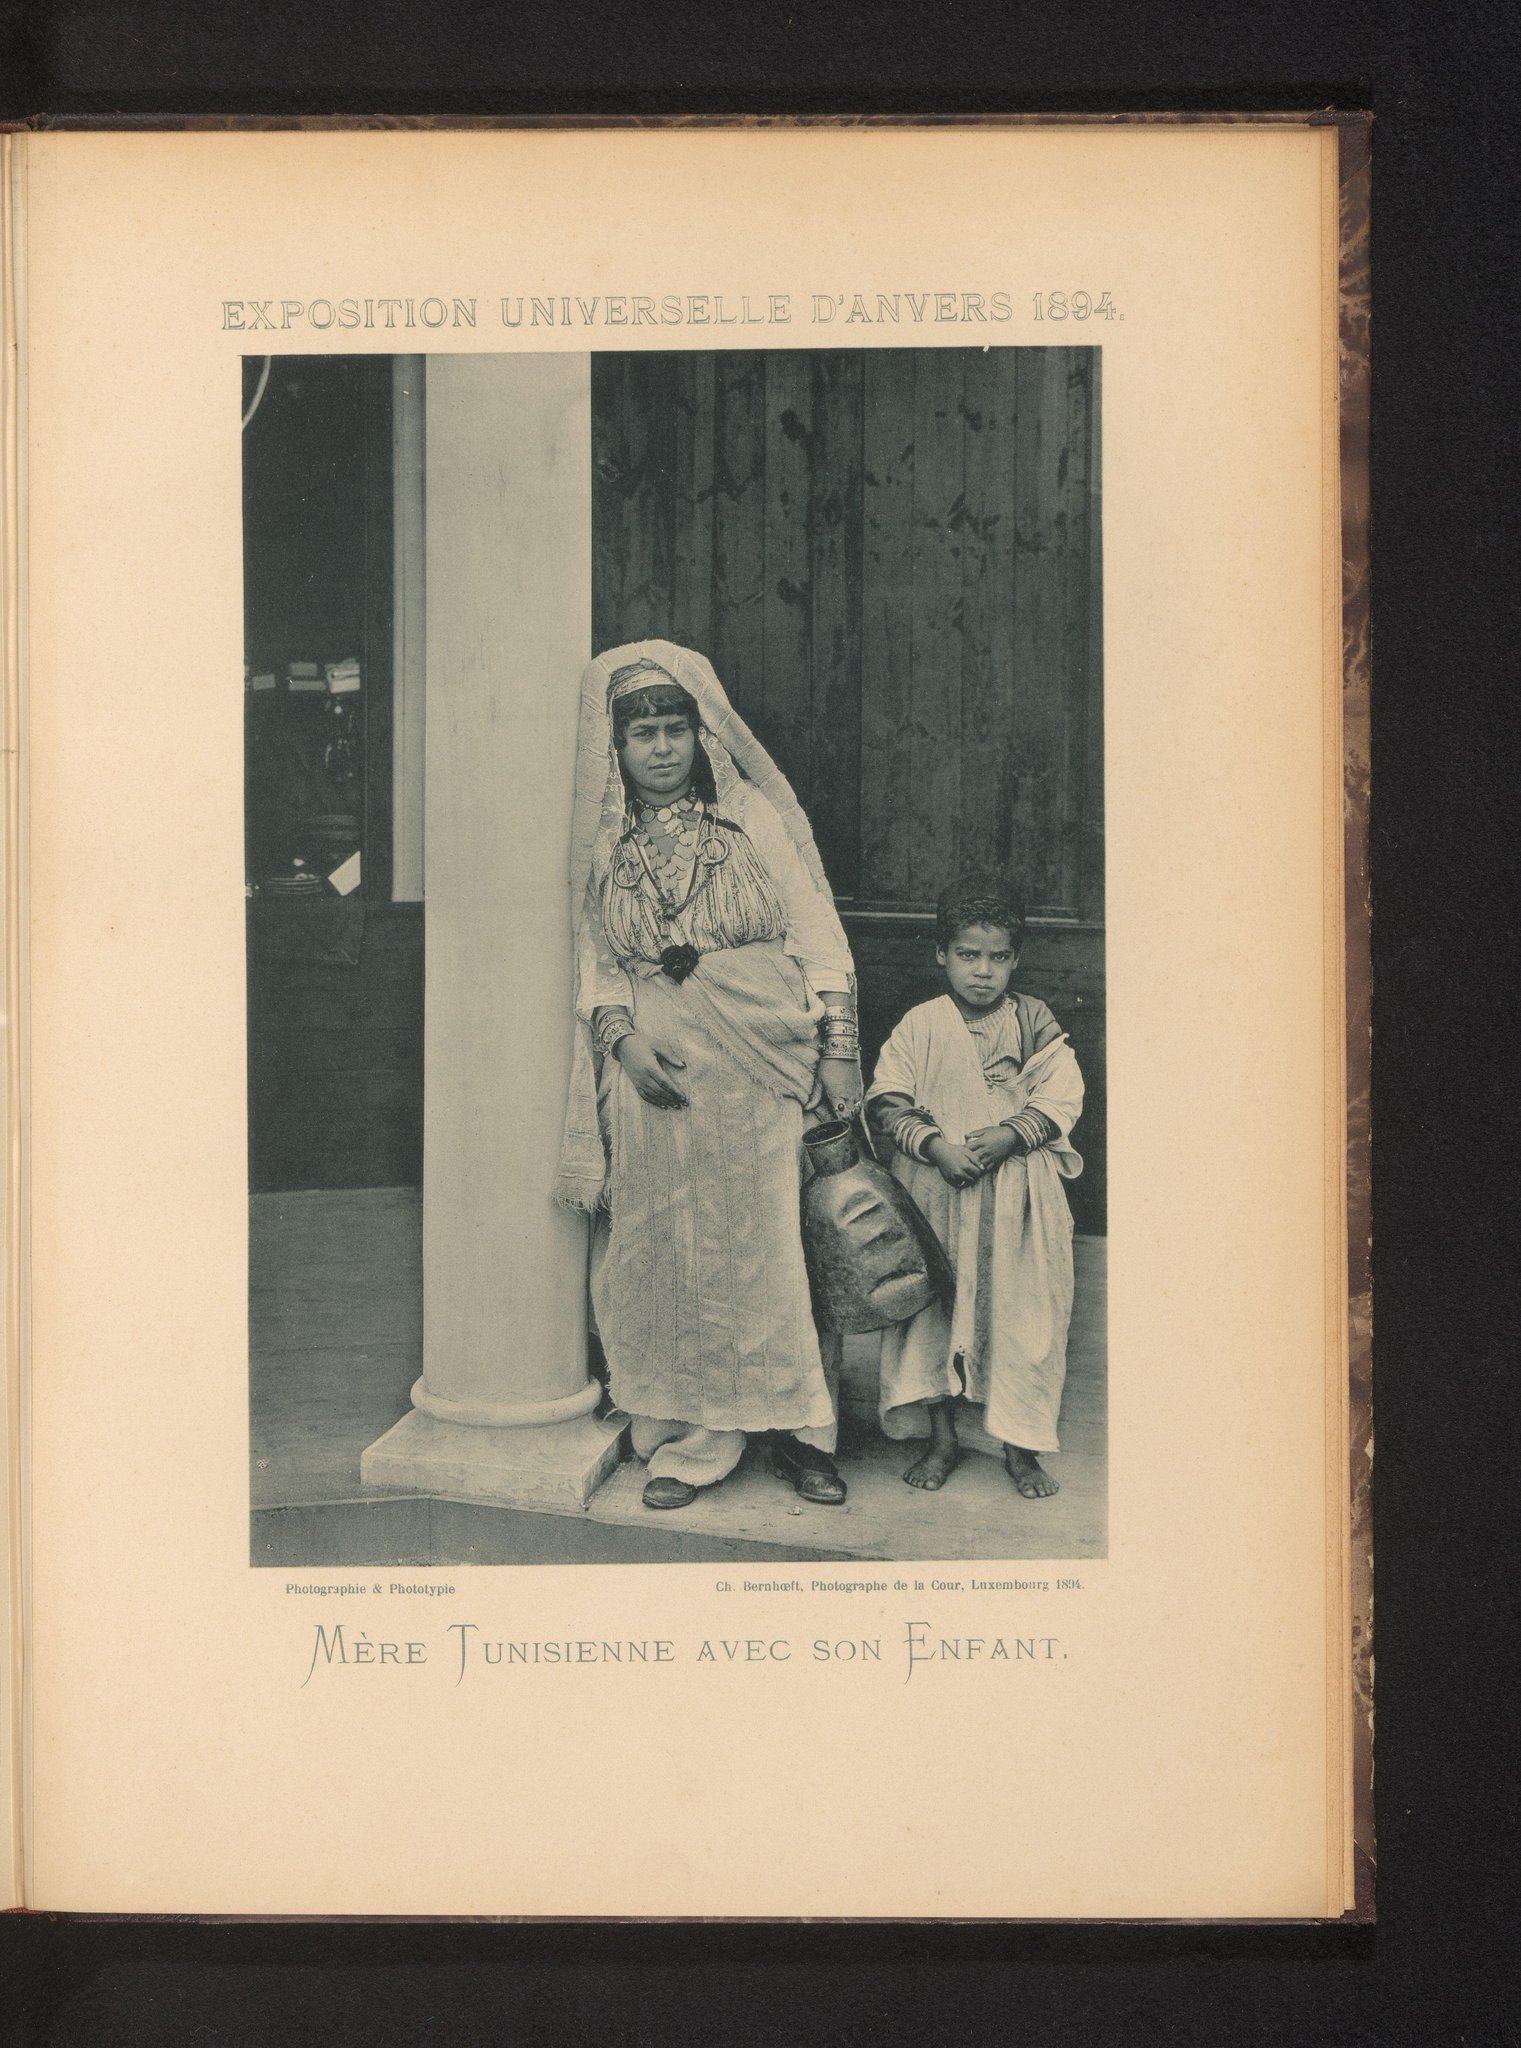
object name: page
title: Moeder en zoon voor een gebouw in het Tunesische deel van de Wereldtentoonstelling van Antwerpen in 1894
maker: charles bernhoeft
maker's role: publisher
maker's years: 1859-1933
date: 1894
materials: paper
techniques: photograph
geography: luxembourg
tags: mother with son(s) and daughter(s) (mother-love), world fair, world exhibition, boy (child between toddler and youth), antwerp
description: Prent op derde ongenummerde pagina na pagina 138.